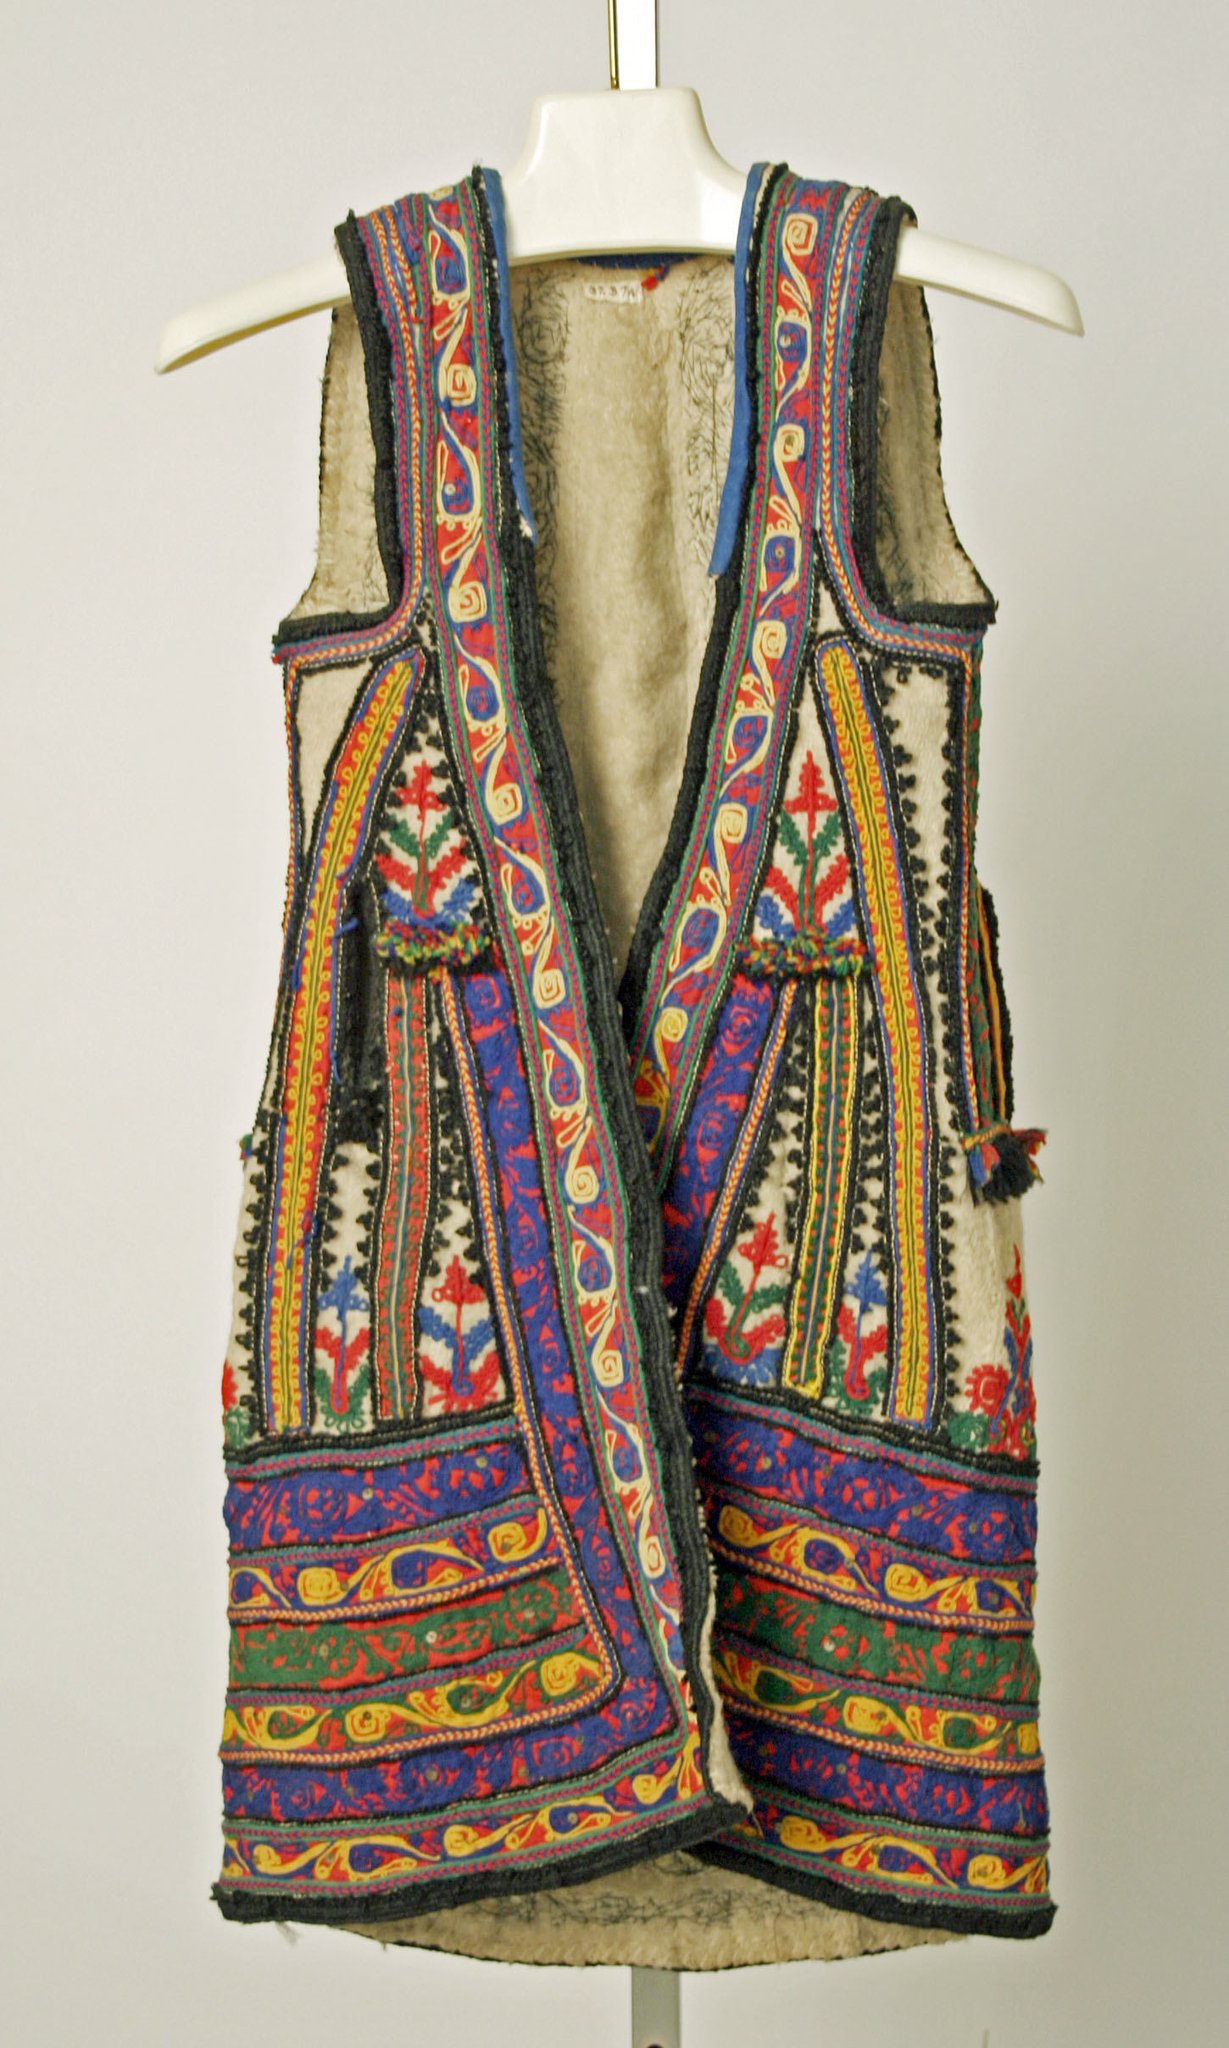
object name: ensemble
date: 1801-1933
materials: wool